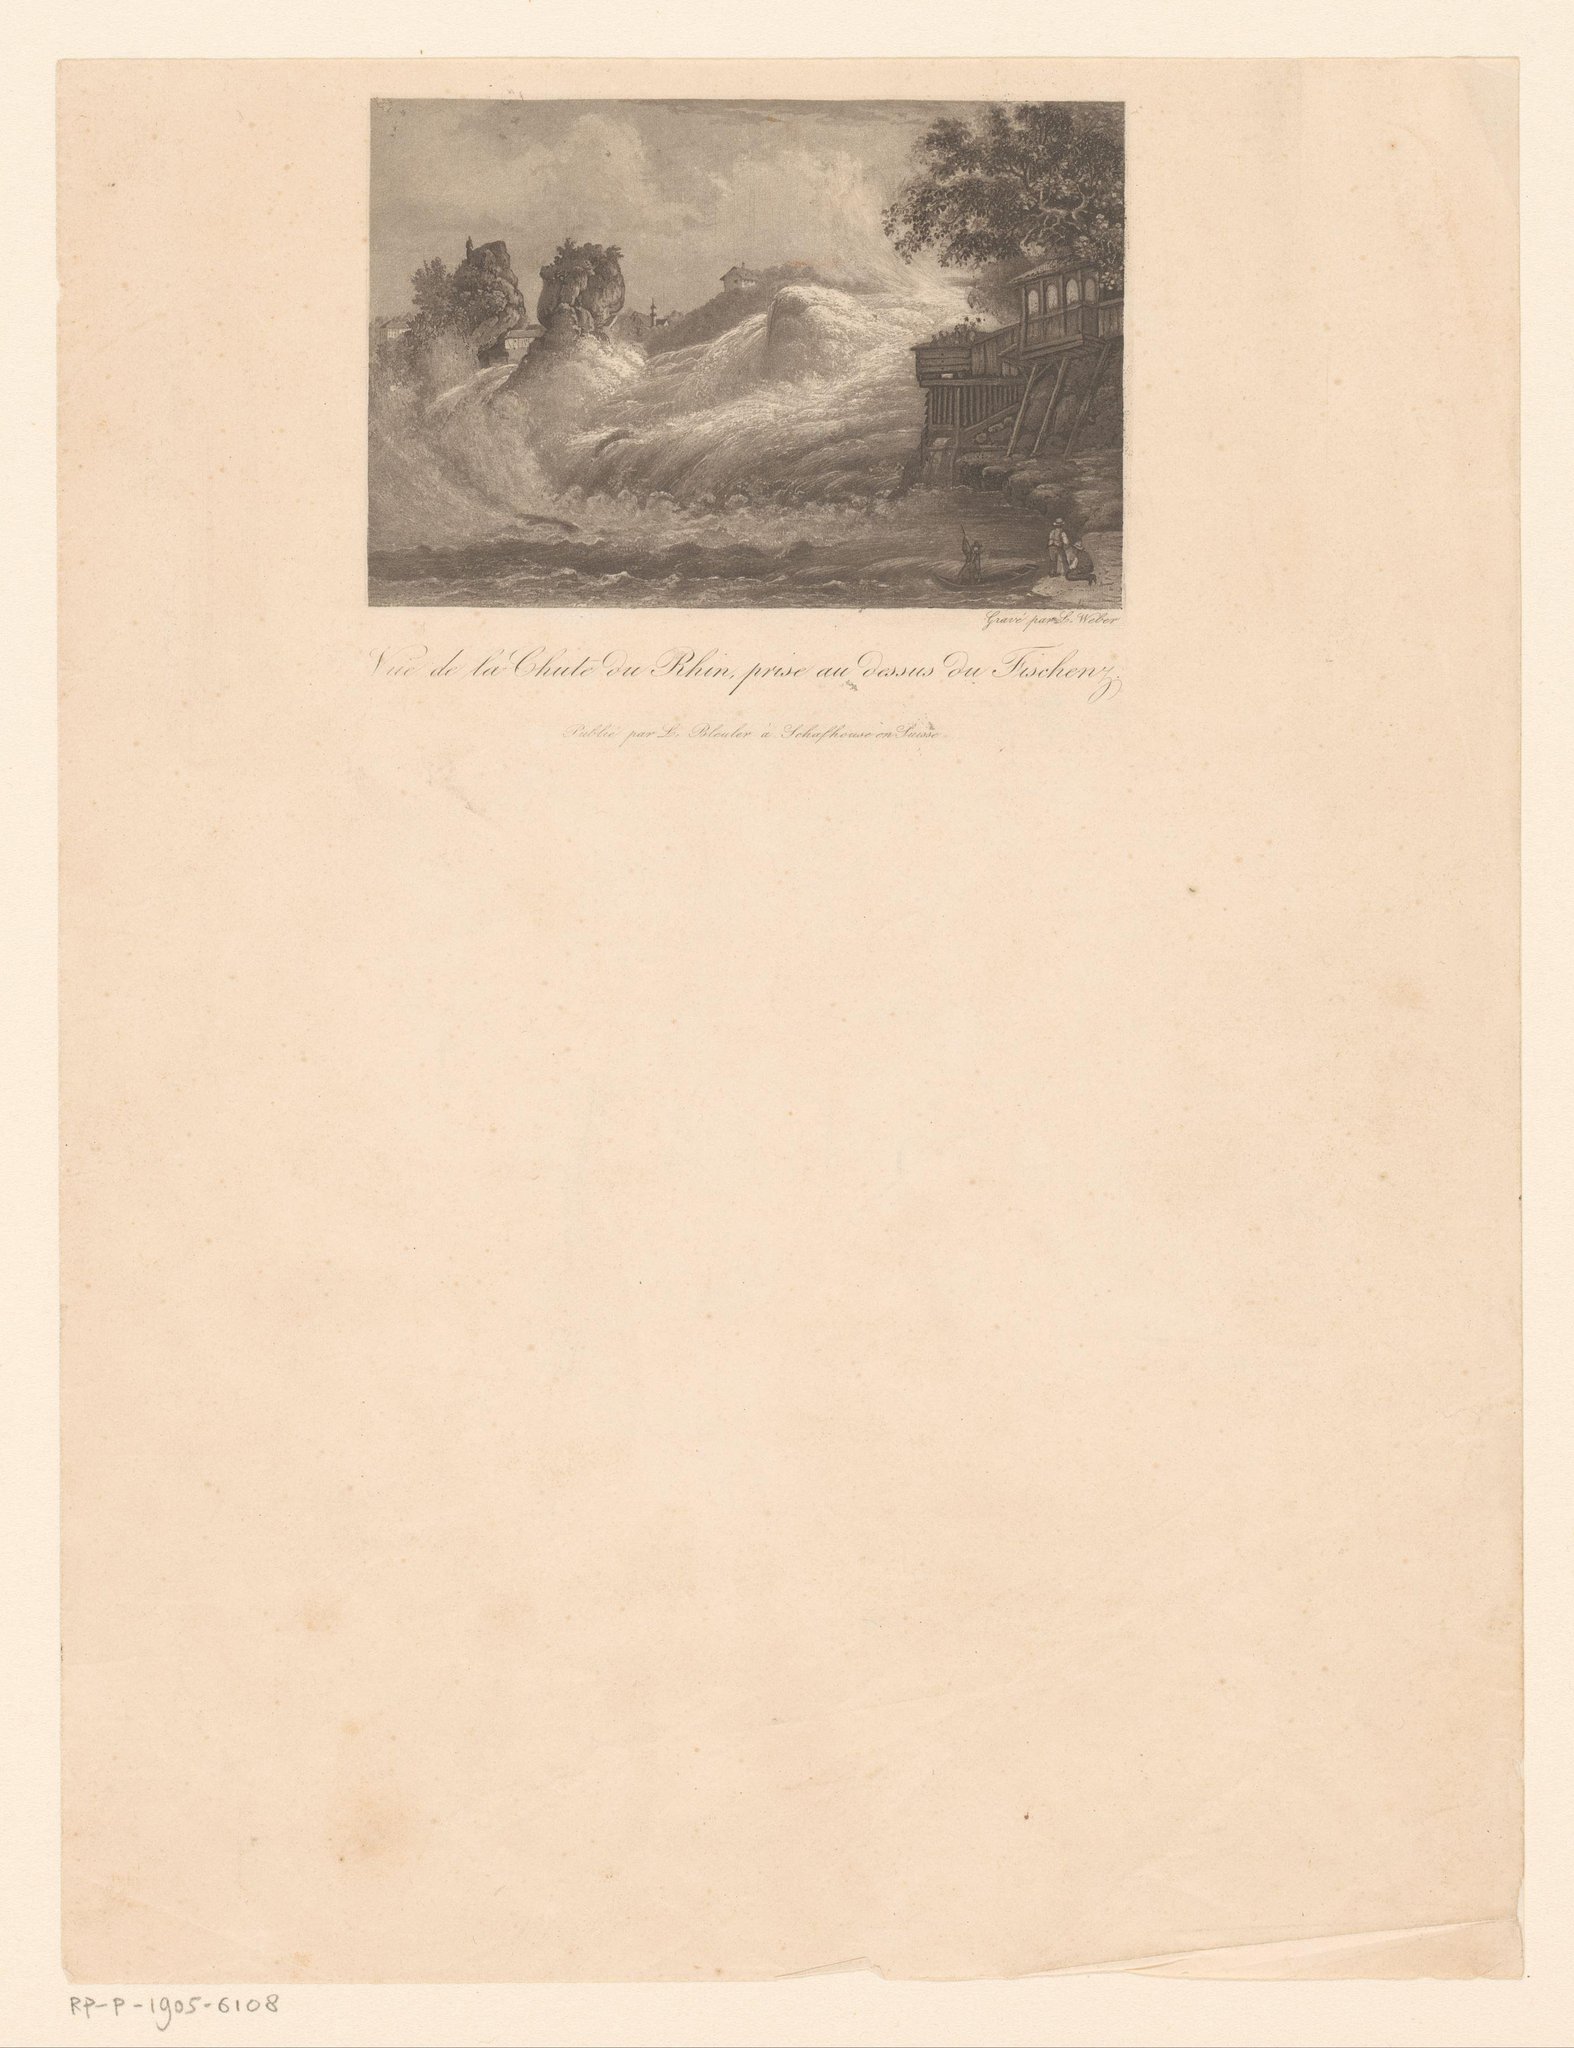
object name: print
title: Vue de la Chute du Rhin, prise au dessus du Fischenz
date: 1821-1850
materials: paper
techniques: aquatint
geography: switzerland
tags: waterfall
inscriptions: collector's mark: Lugt 2228